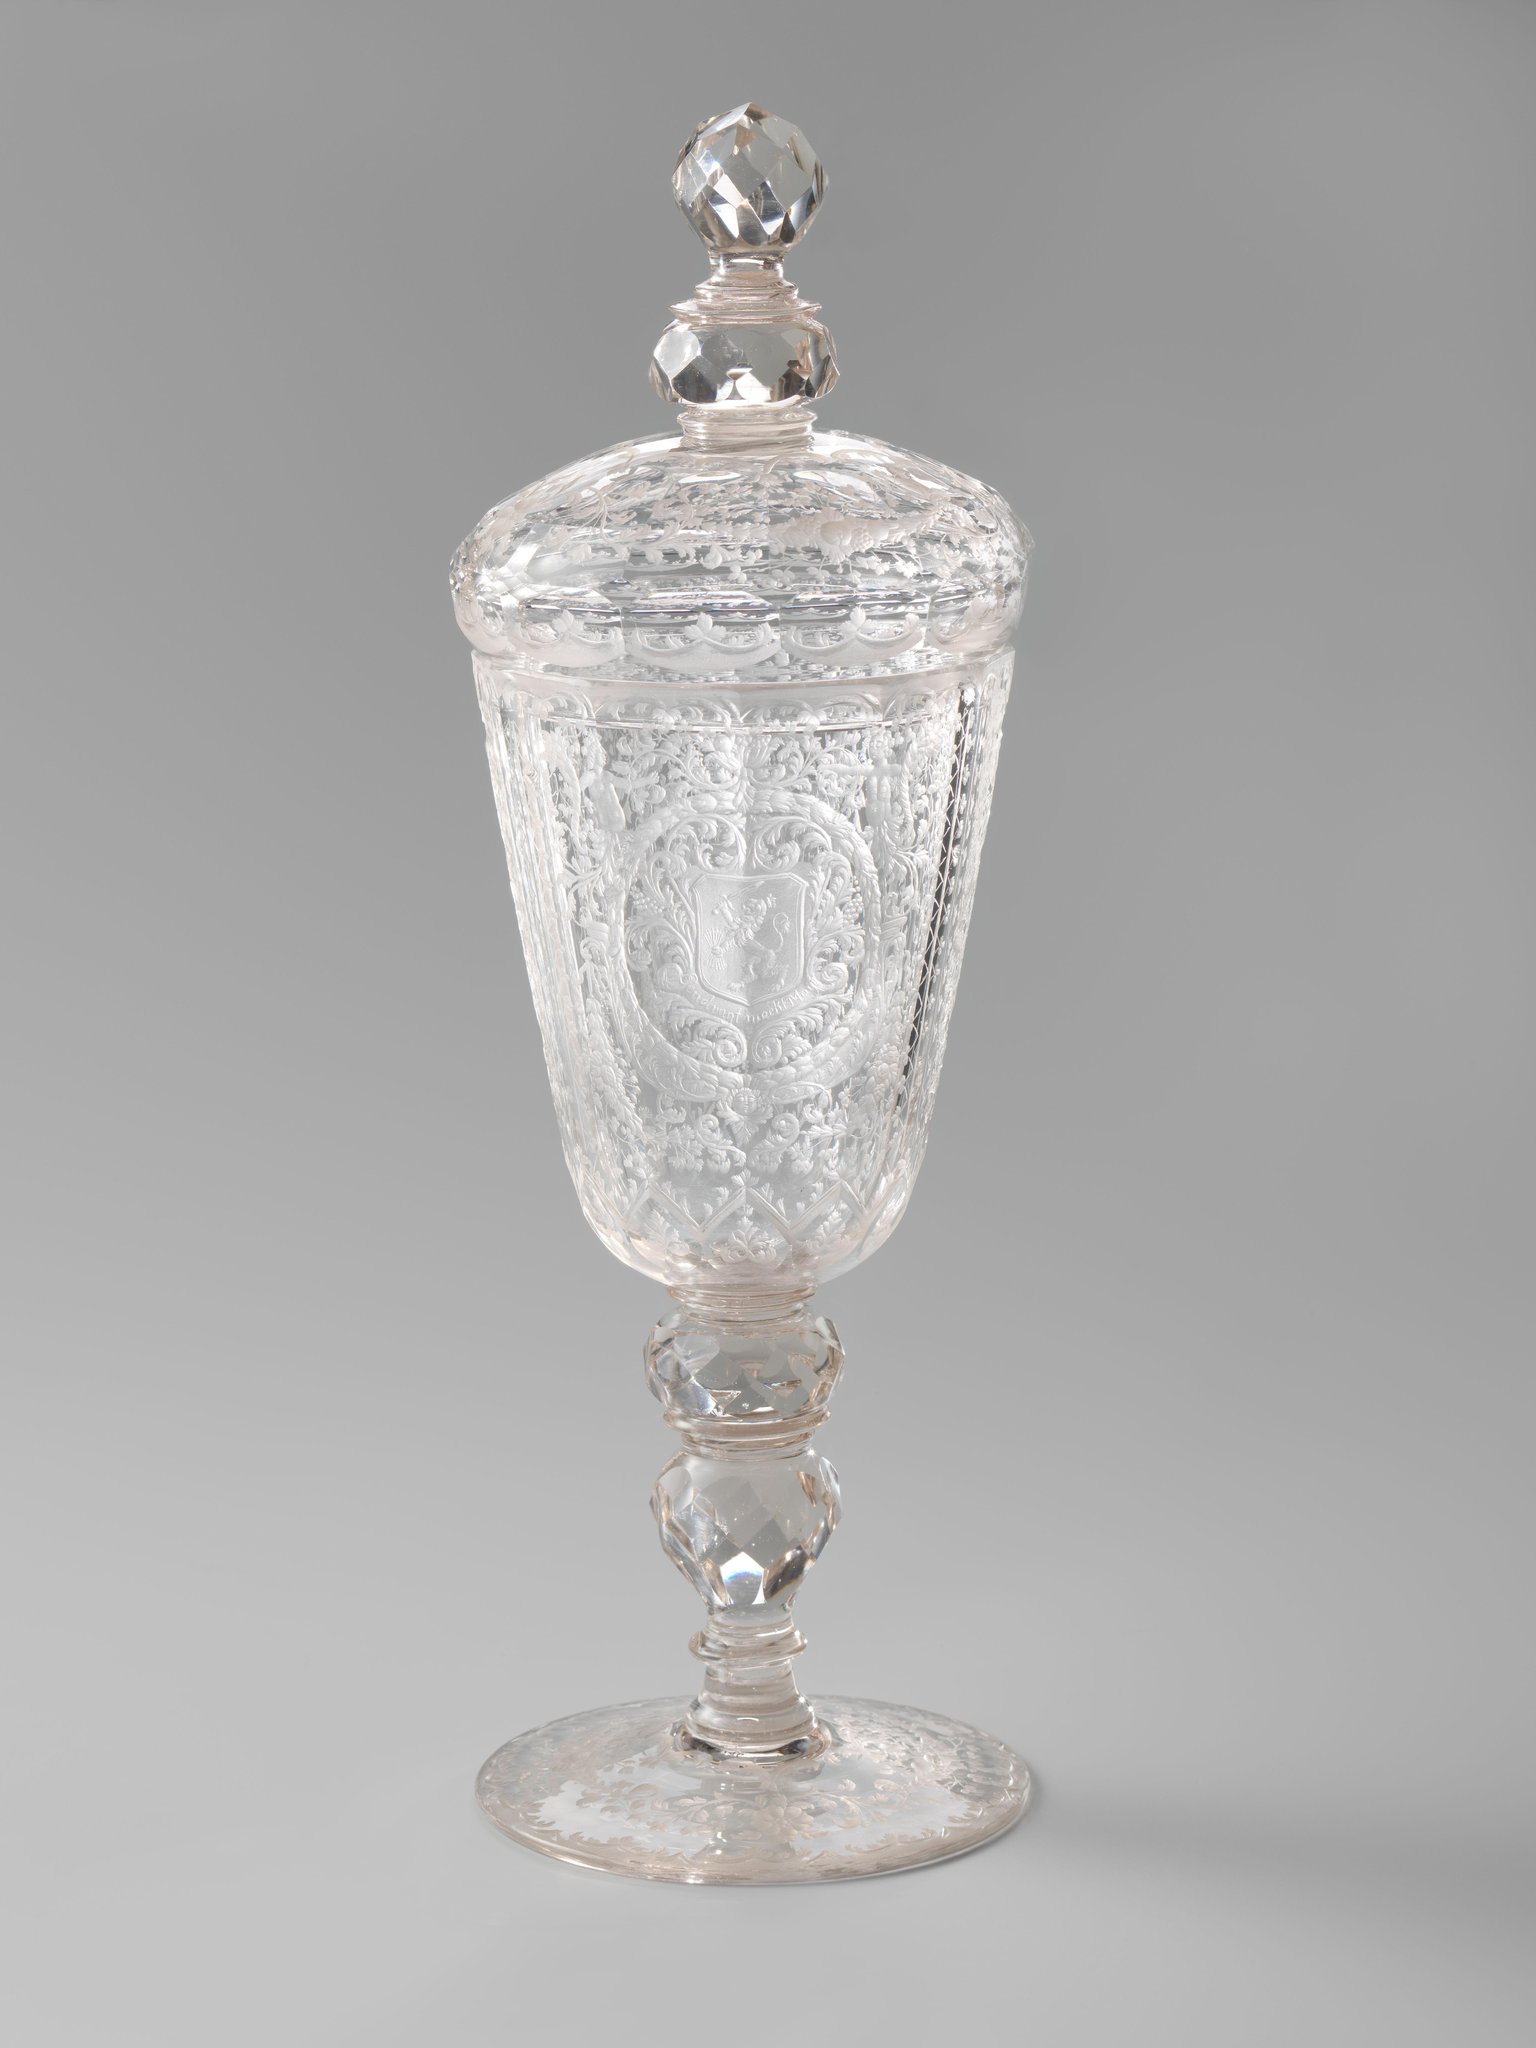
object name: lid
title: Lidded wine glass with the arms of Diderik Dicx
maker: Anonymous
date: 1708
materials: glass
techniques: glassblowing, grinding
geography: bohemia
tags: haarlem, armorial bearing, heraldry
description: Het facetgeslepen, gewelfde deksel met facetgeslepen bekroning, bestaande uit een knop die wordt bekroond door een bol. Op het deksel bloem- en bladranken en rosetten.